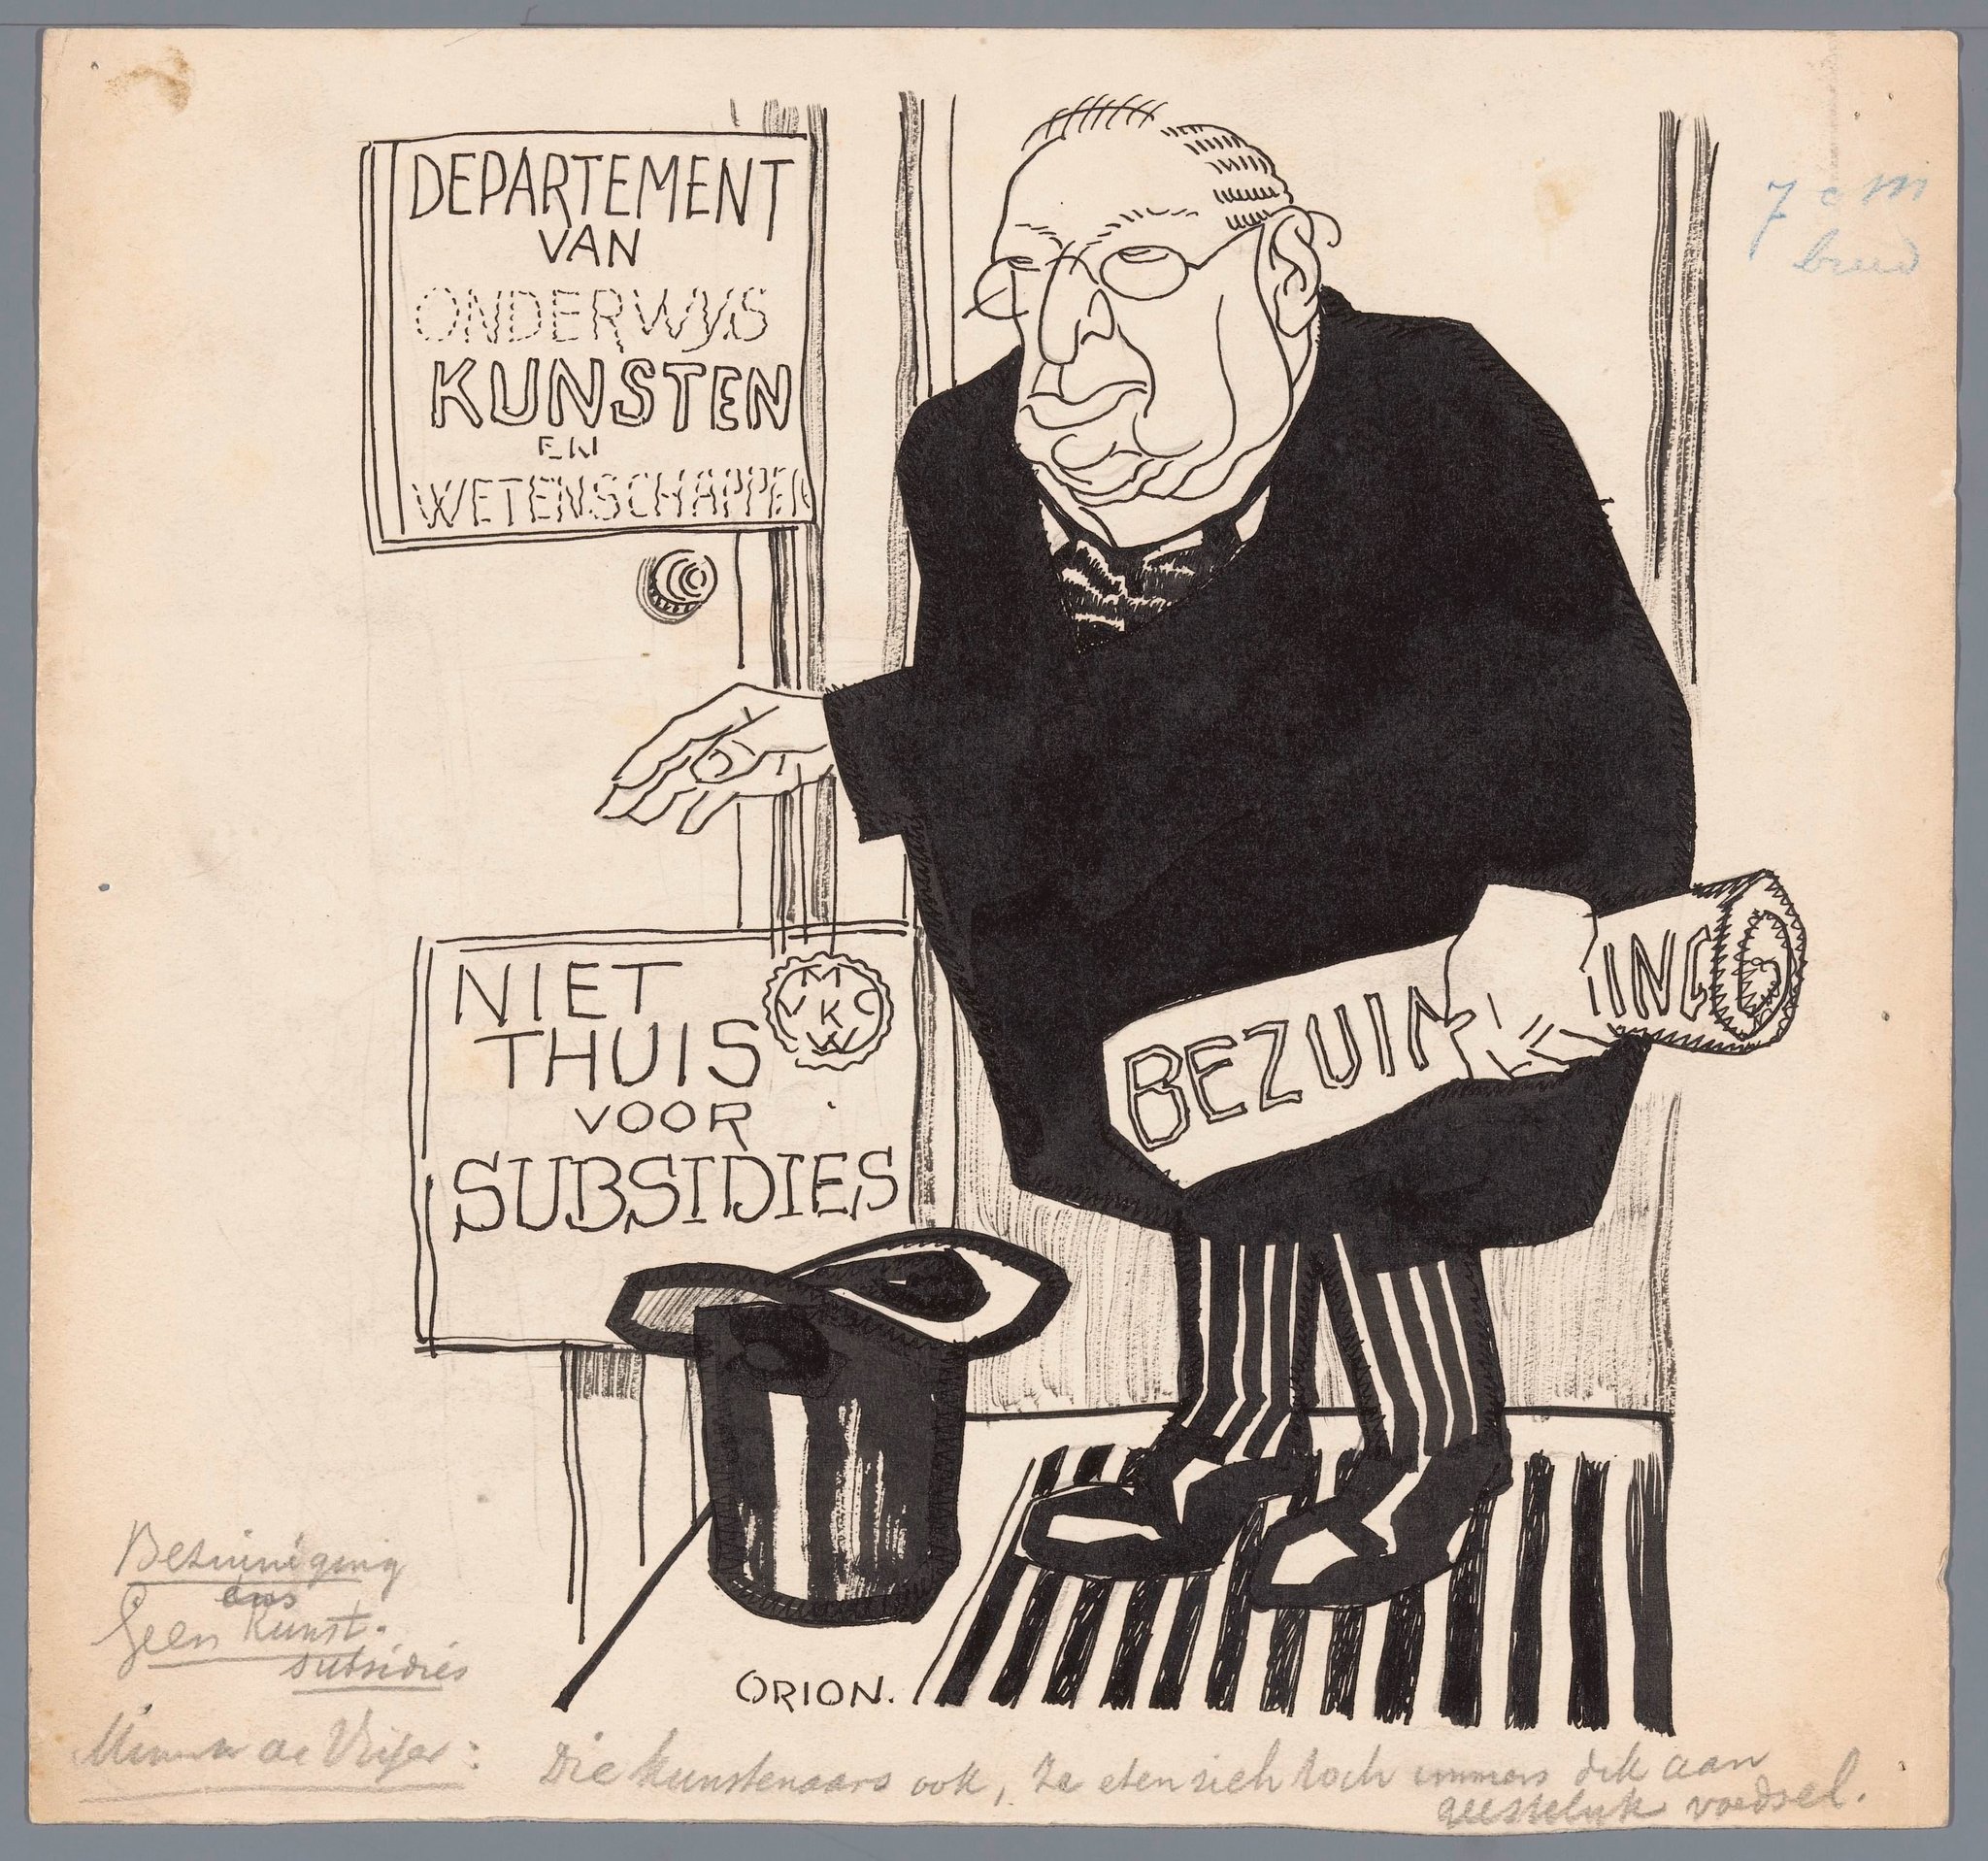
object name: drawing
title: Minister de Visser en de bezuinigingen op kunstsubsidies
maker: patricq kroon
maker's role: draughtsman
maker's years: 1862-1941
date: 1918-1925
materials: ink, paper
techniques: brush, pen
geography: netherlands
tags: utrecht, minister ~ government, political caricatures and satires, netherlands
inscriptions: inscription: ‘Bezuiniging Geen kunst subsidies / Minister de Visser: Die kunstenaars ook, ze eten zich toch immers dik aan geestelijk voedsel’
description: Minister J.T. de Visser van Onderwijs, Kunsten en Wetenschappen (1918-25) bezuinigt op de subsidies voor kunstenaars. Ontwerp voor een politieke spotprent.